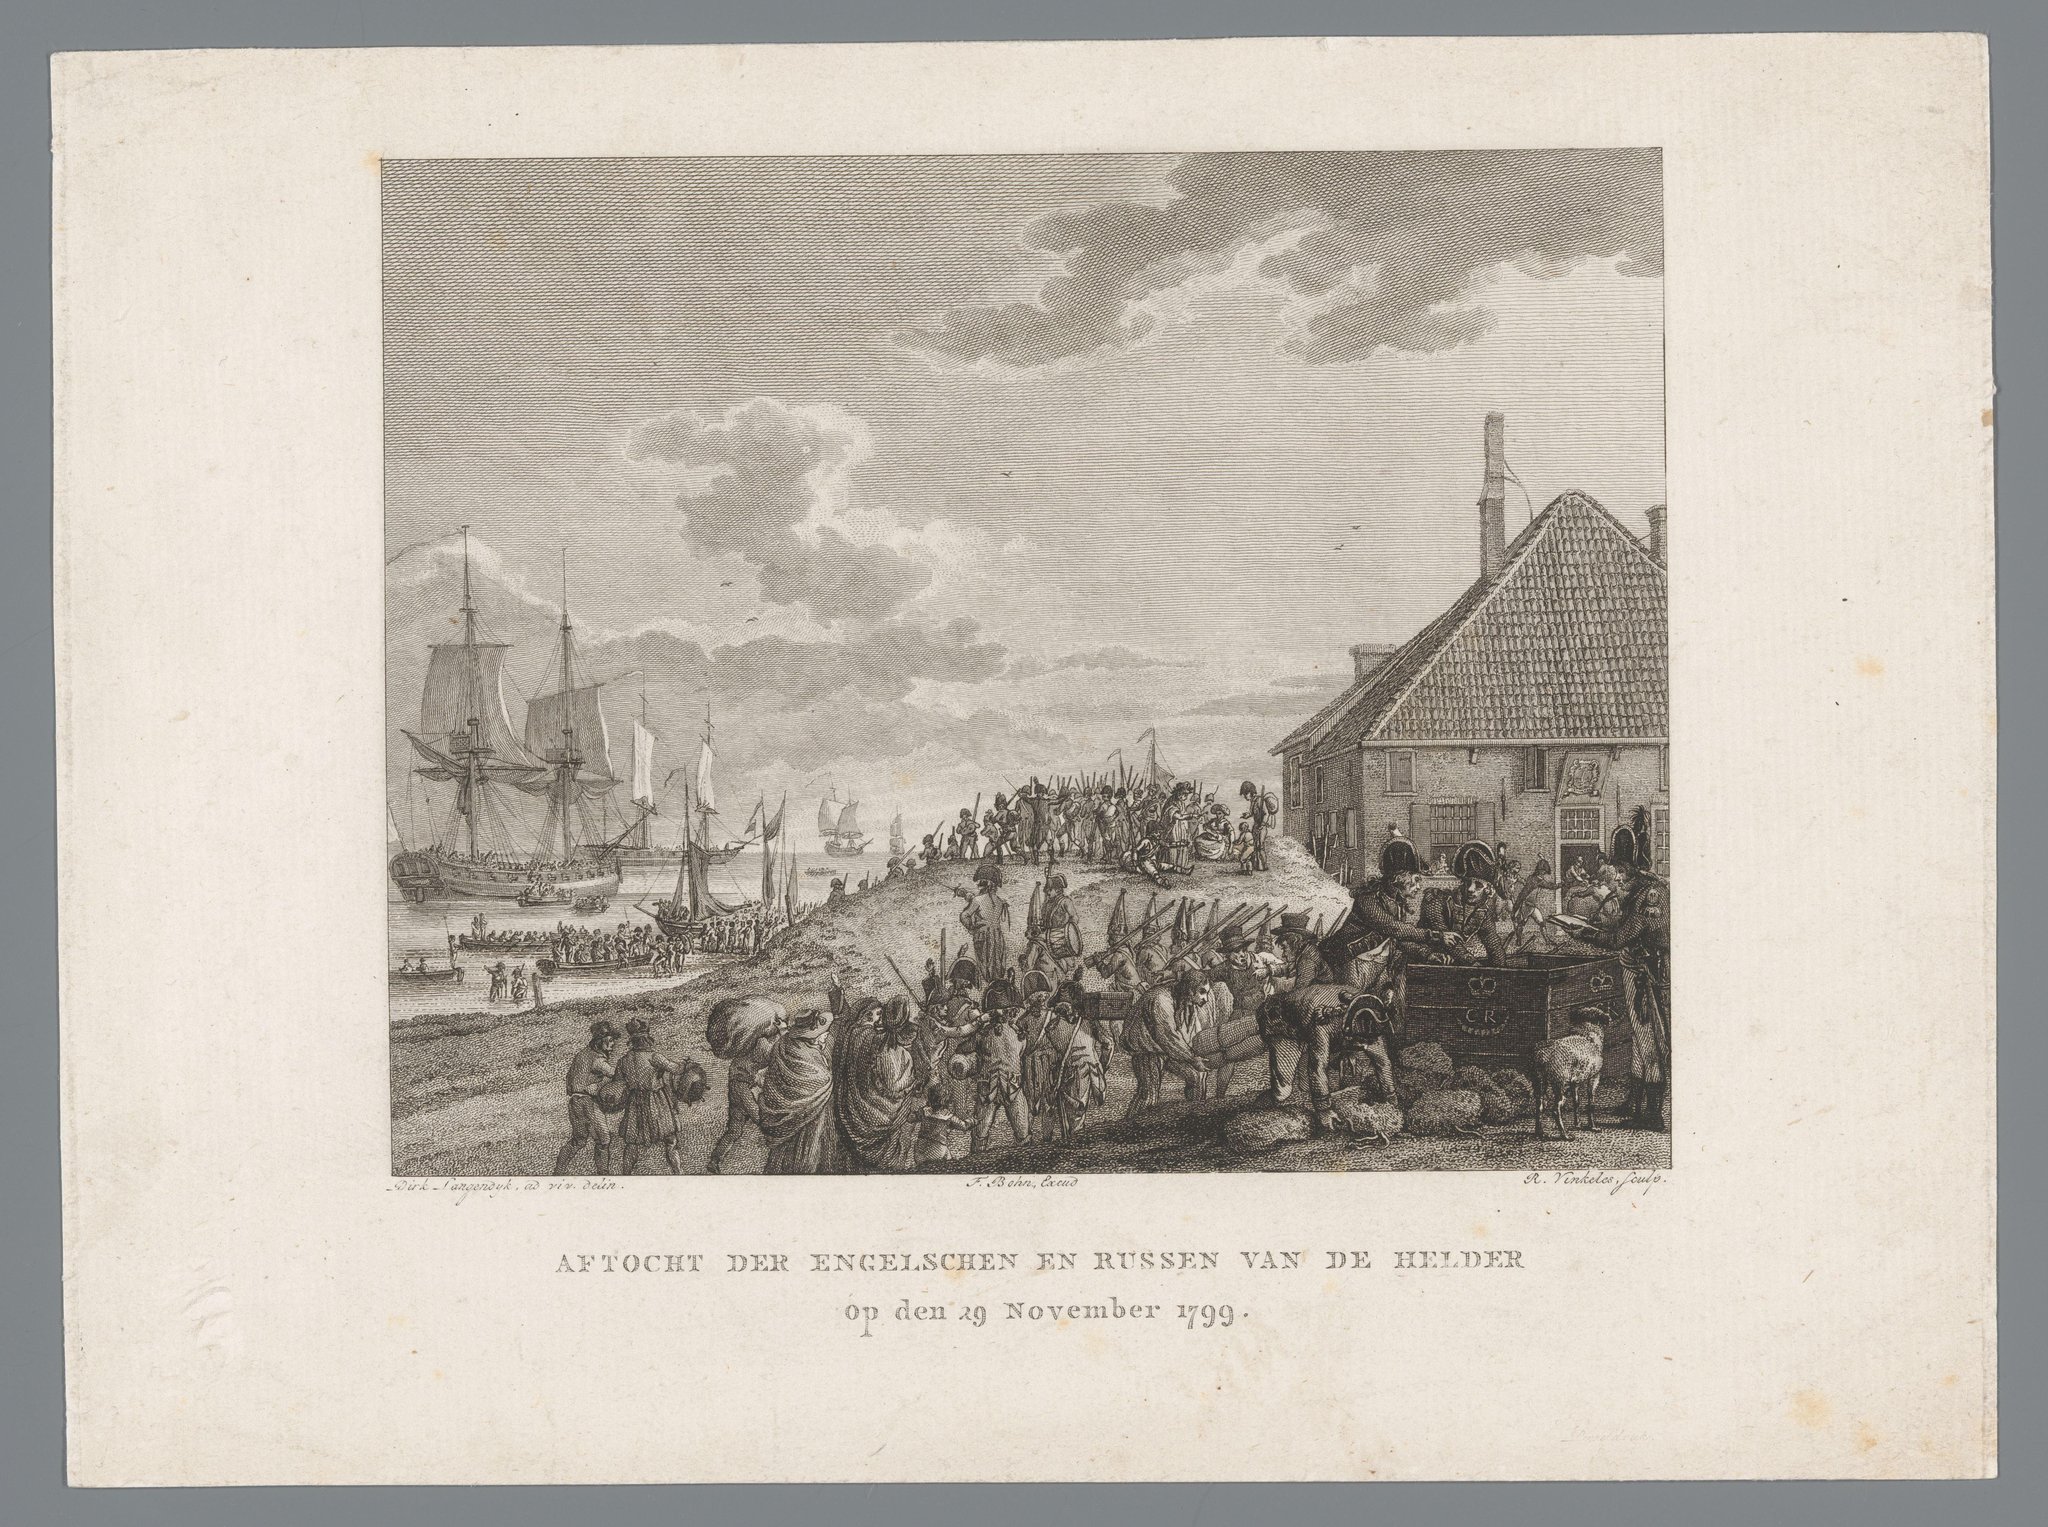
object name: book illustration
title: Aftocht der Engelschen en Russen van De Helder Op den 29 November 1799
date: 1801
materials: paper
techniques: etching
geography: amsterdam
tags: troop movements, transportation, coast, den helder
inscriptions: collector's mark: Lugt 2228, collector's mark: Lugt 2233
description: Prent uit: Vonk, L.C. Geschiedenis der landing van het Engelsch-Russisch leger in Noord-Holland; alsmede der krijgsbedrijven en politieke gebeurtenissen, zoo aldaar, als in Vriesland en Gelderland, in den jare 1799. Haarlem: François Bohn, 1801, dl. 2, tussen p. 184 en 185.